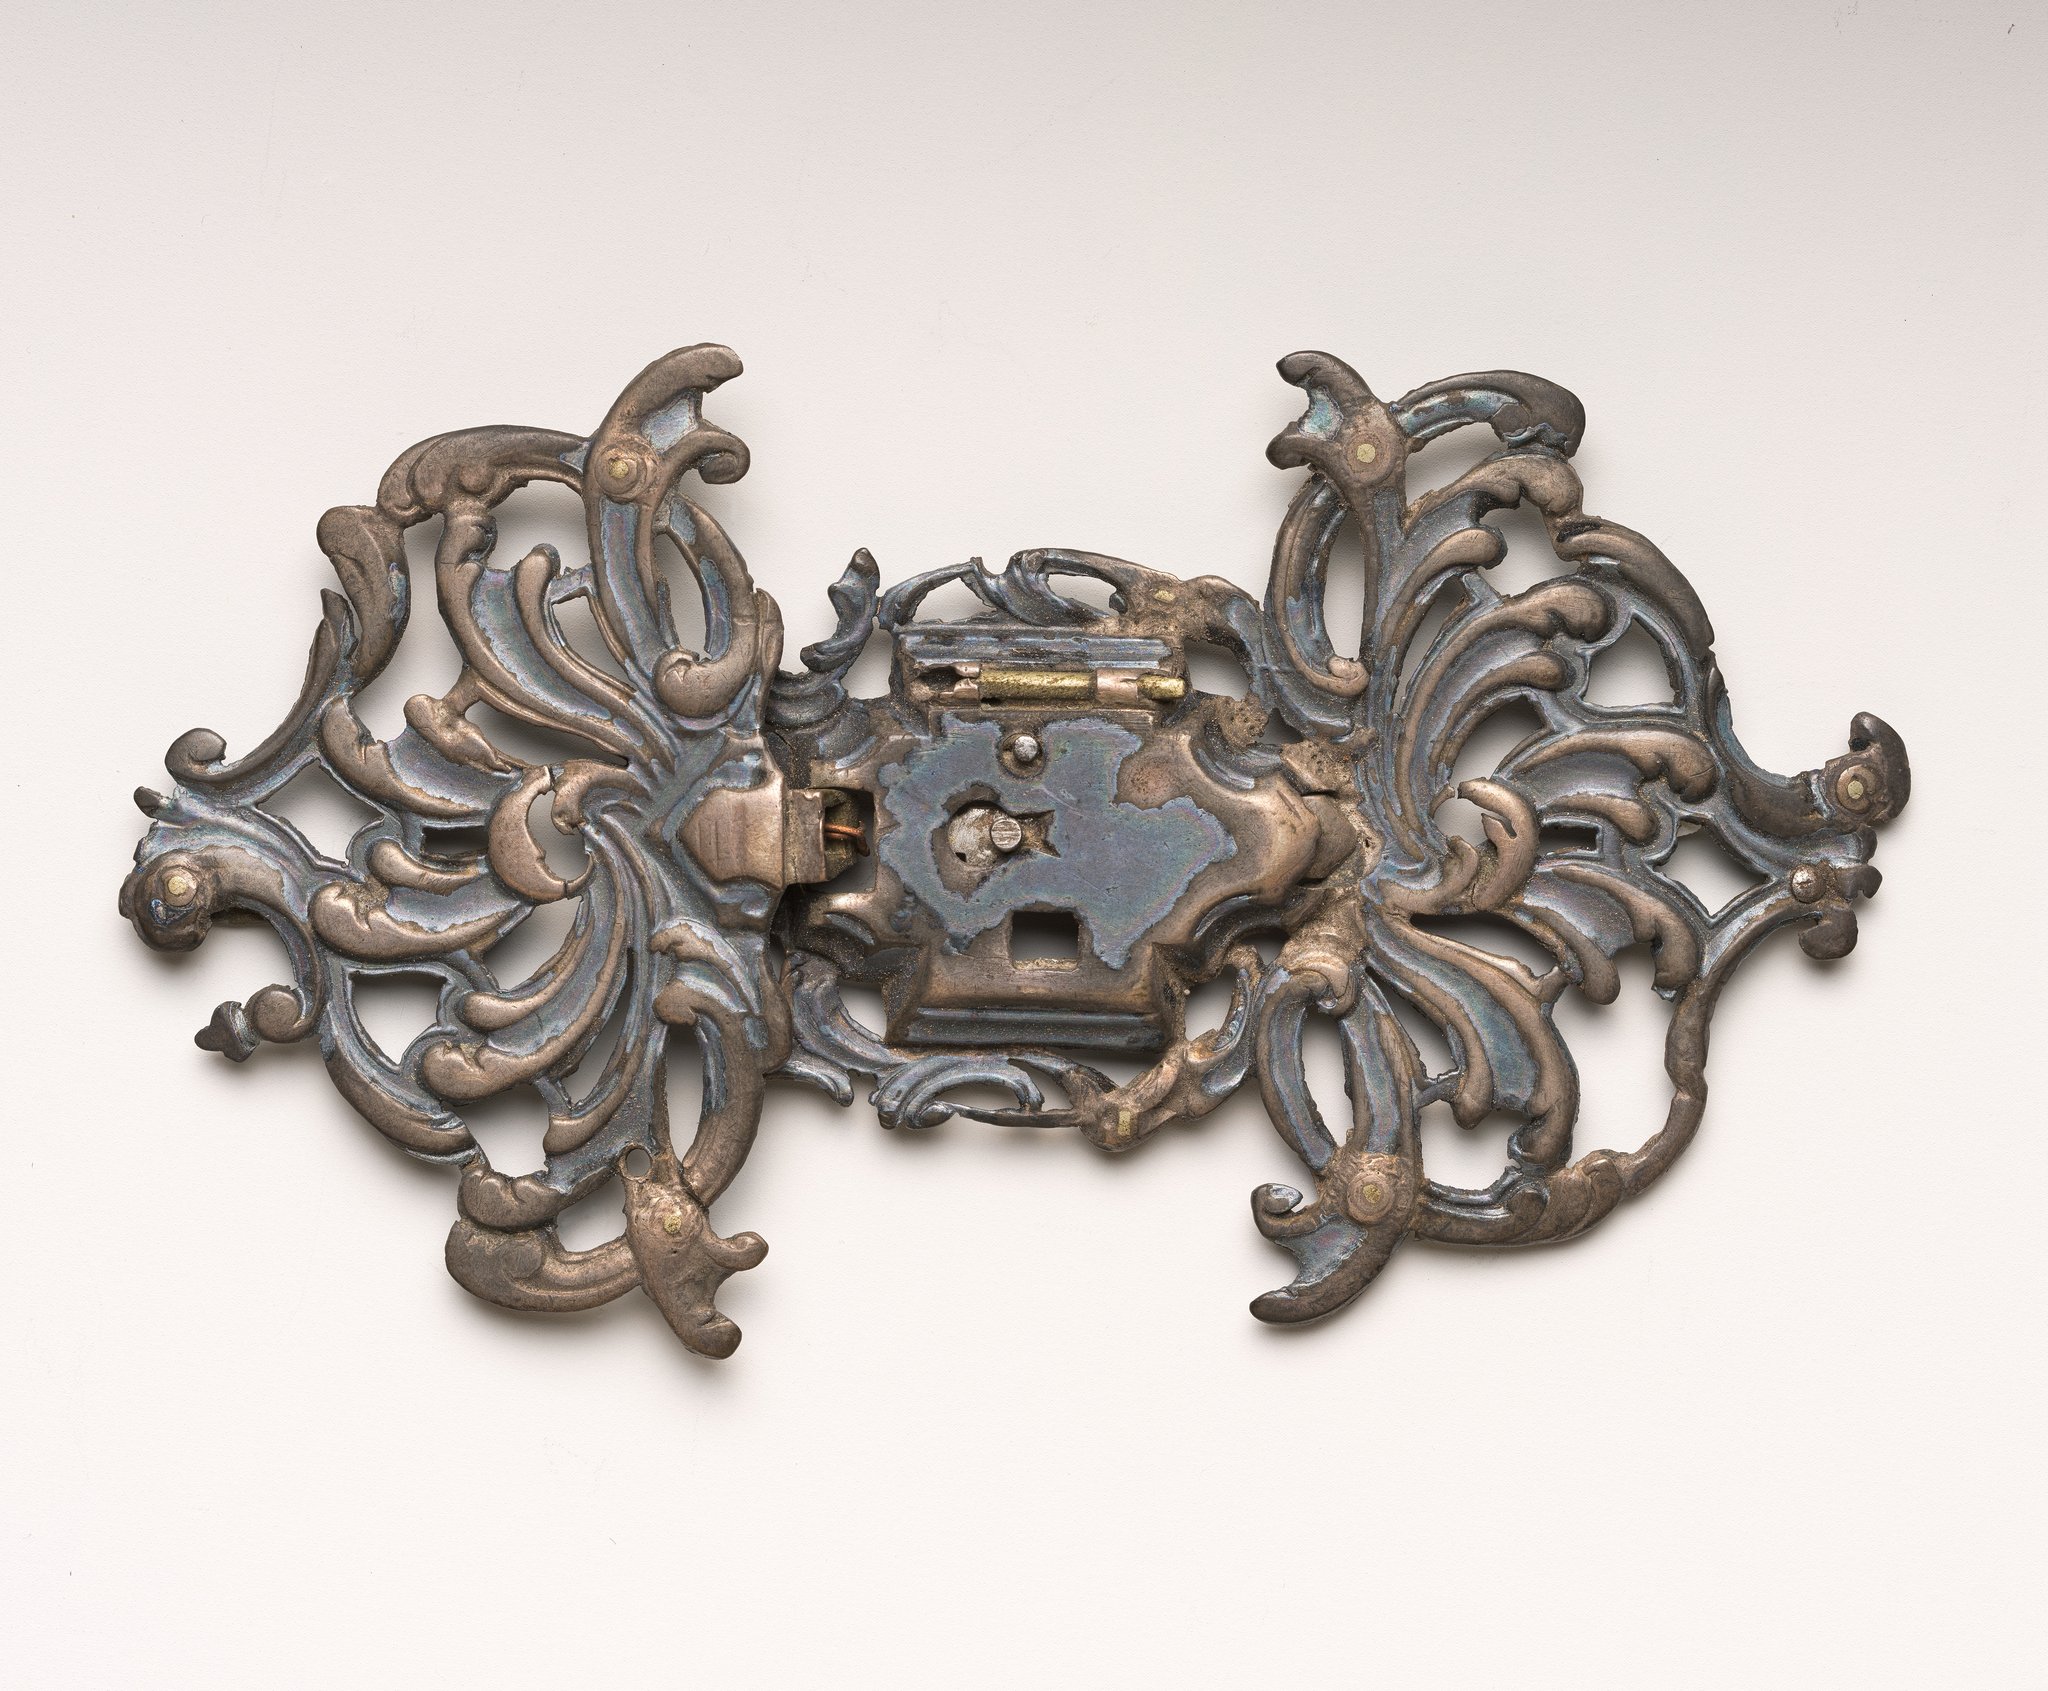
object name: lock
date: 1701-1800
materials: silver